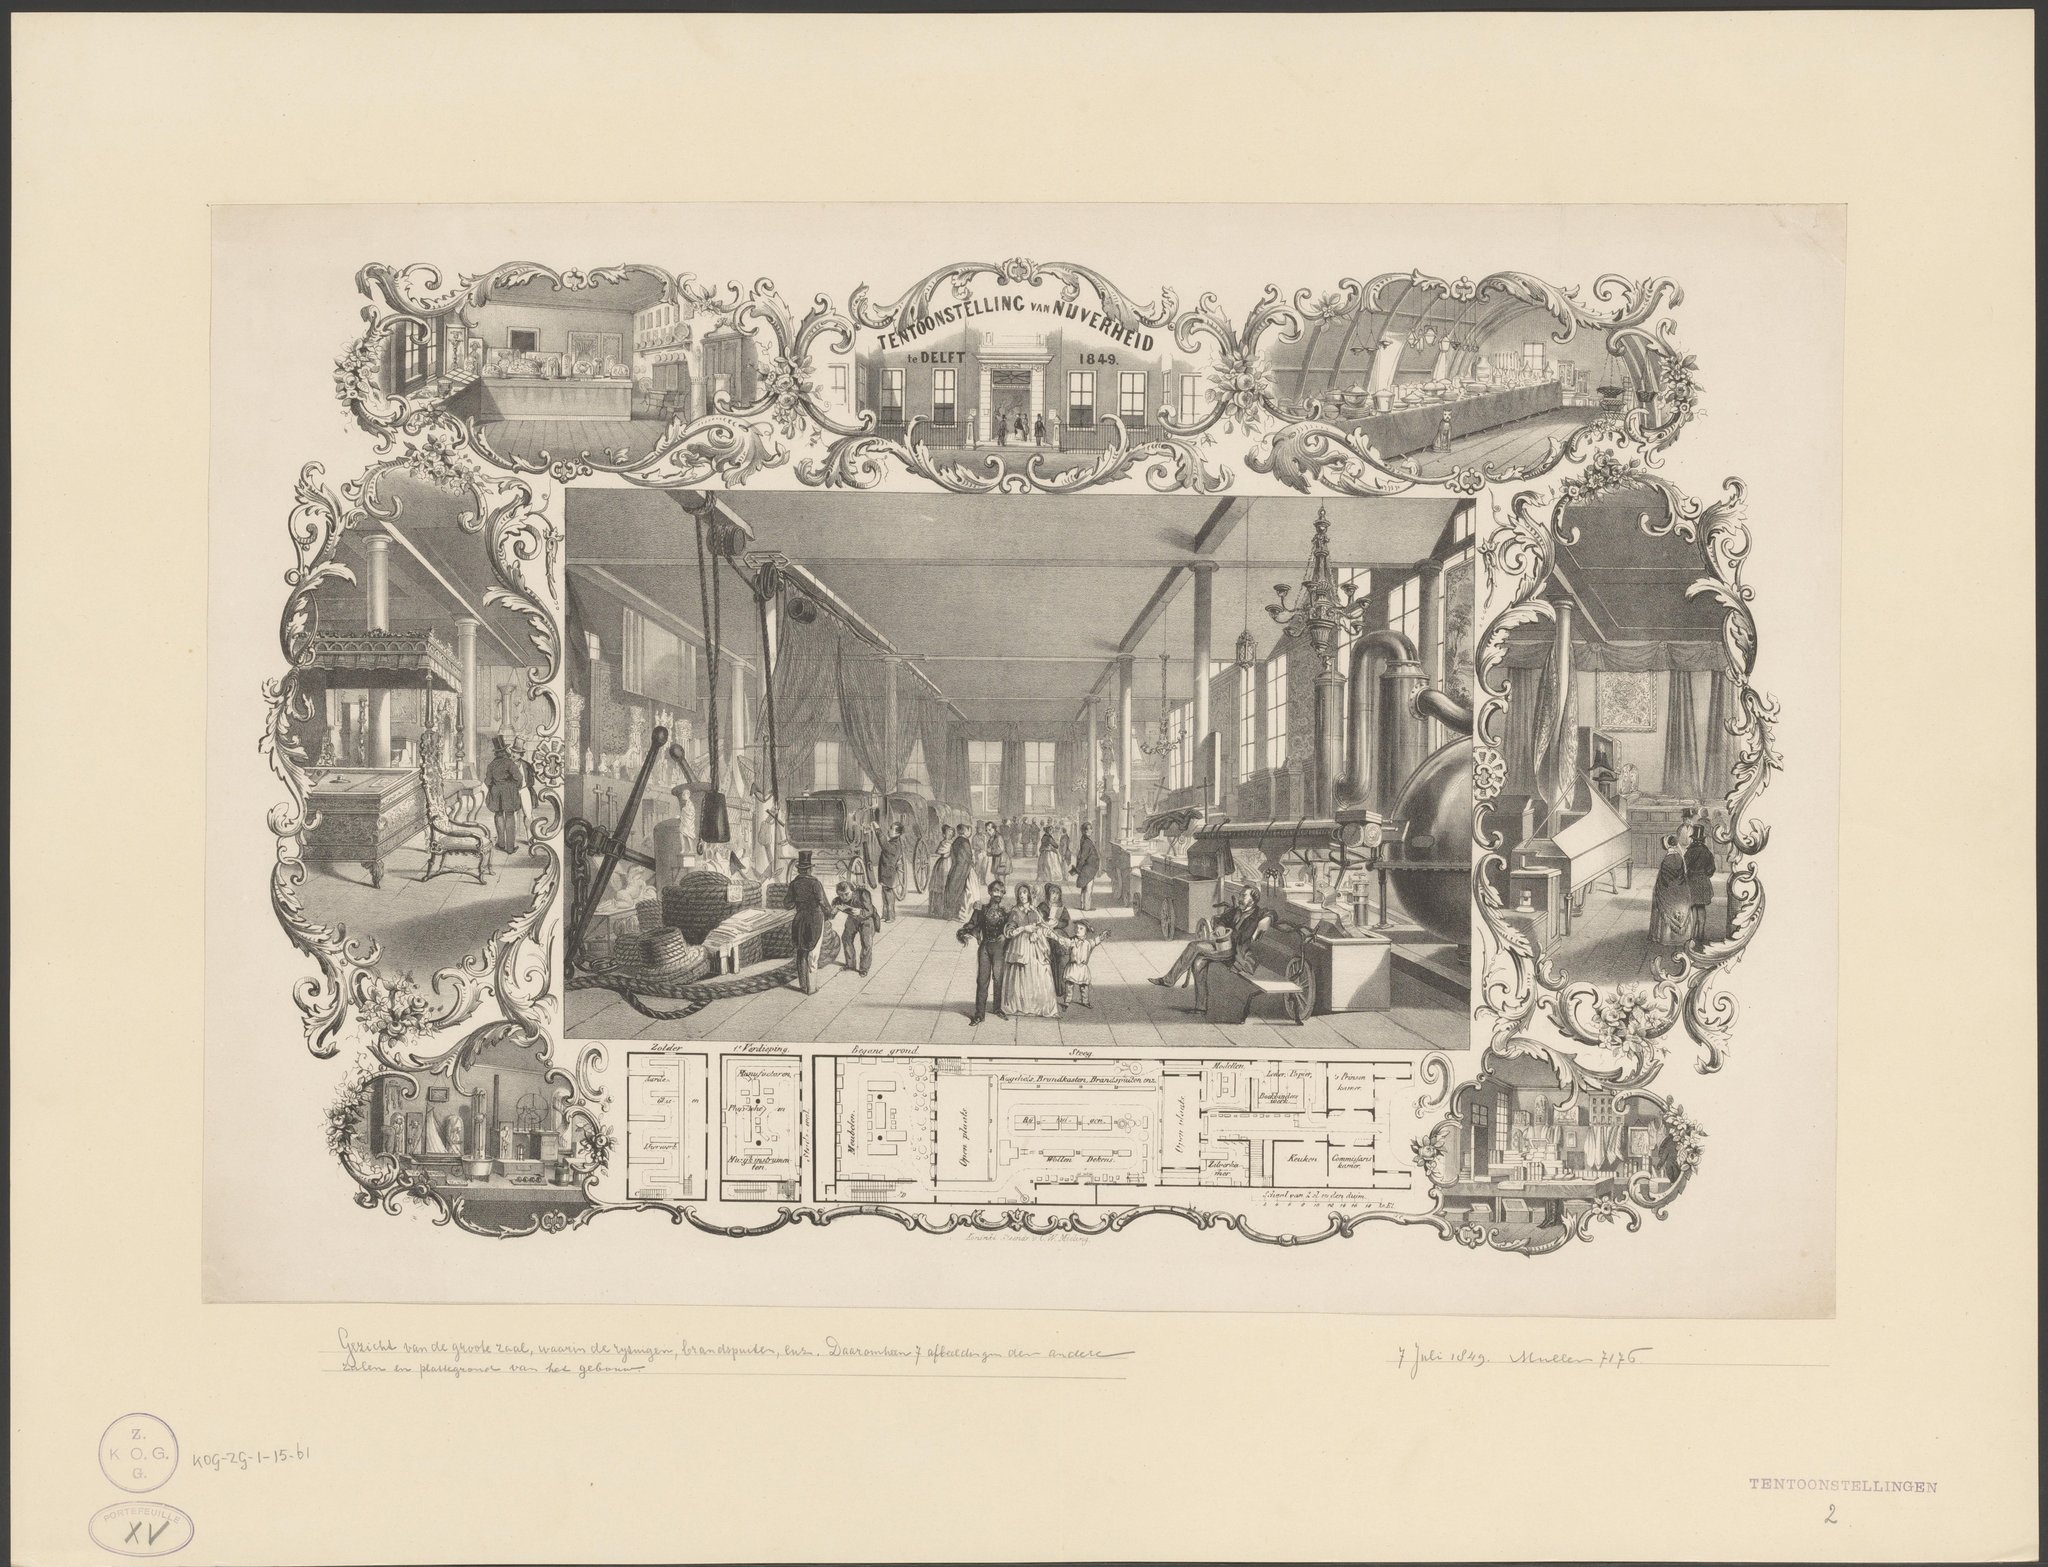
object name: print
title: Tentoonstelling van Nijverheid te Delft, 1849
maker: Anonymous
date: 1849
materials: paper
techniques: lithograph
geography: the hague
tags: trade exhibition, industries fair, delft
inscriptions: collector's mark: Lugt 1641, stamp, stamp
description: Gezicht in de grote zaal van de Tentoonstelling van Nijverheid gehouden in het hoofdgebouw van de 'Koninklijke Akademie ter opleiding van burgerlijke ingenieurs zoo voor 's lands dienst als voor de nijverheid en van kweekelingen voor den handel' te Delft, juli 1849. In de zaal scheepsbenodigdheden, brandspuiten, rijtuigen een (stoom)machine. Om de centrale voorstelling staan zeven gezichten in de andere zalen van de tentoonstelling en een plattegrond van de tentoonstelling. Onderwerpsrubrieken binnen de Atlas Zeden en Gewoonten: Handel, nijverheid en verkeer, Tentoonstellingen.